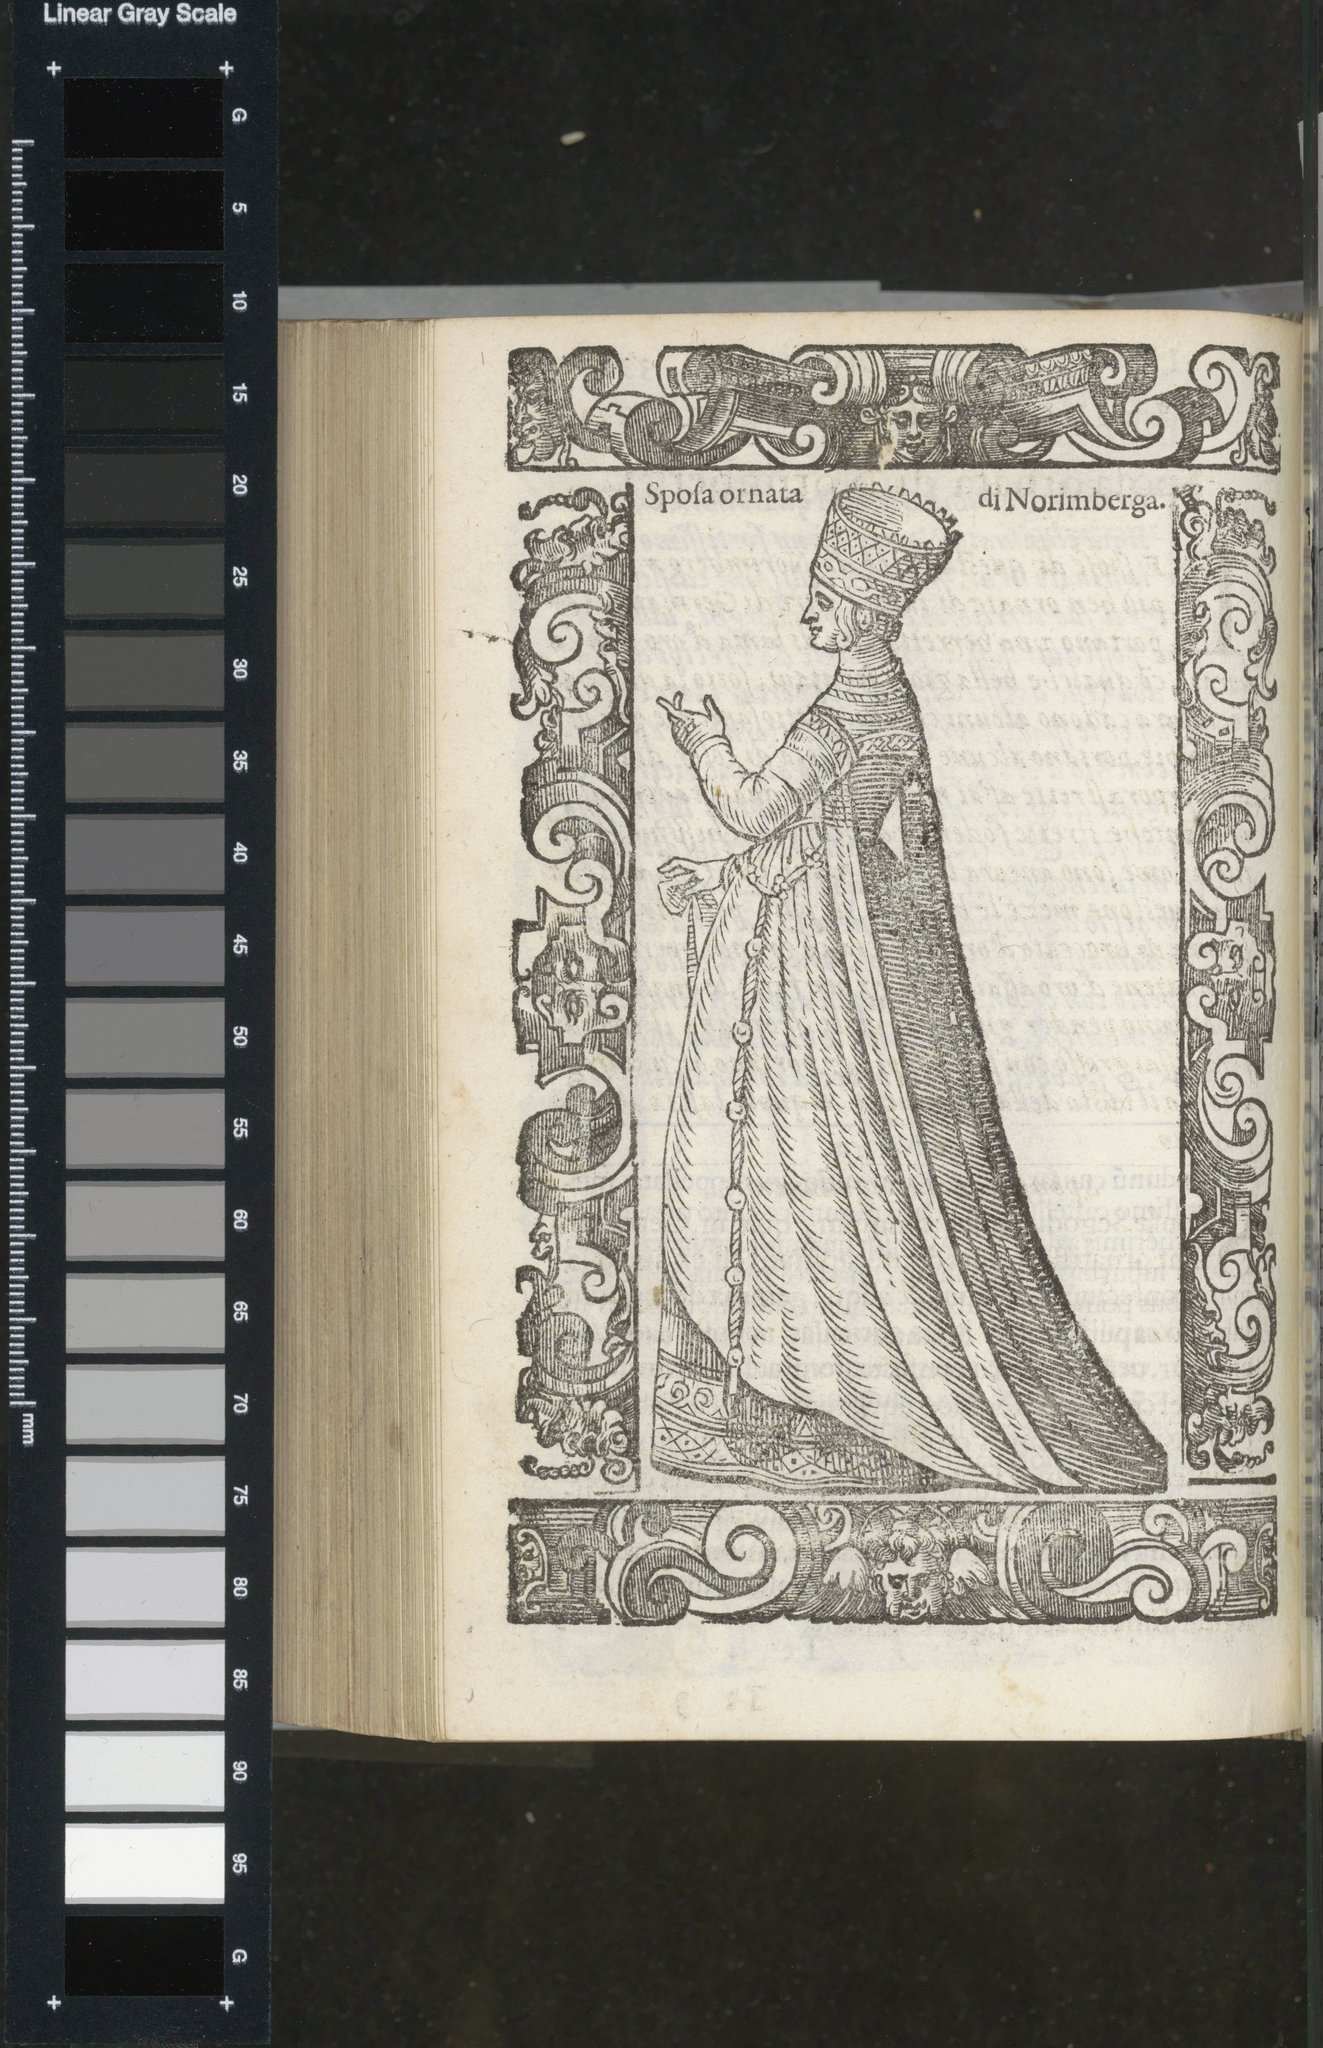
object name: costume print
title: Sposa ornata di Norimberga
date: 1598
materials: paper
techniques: woodcut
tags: fashion plates